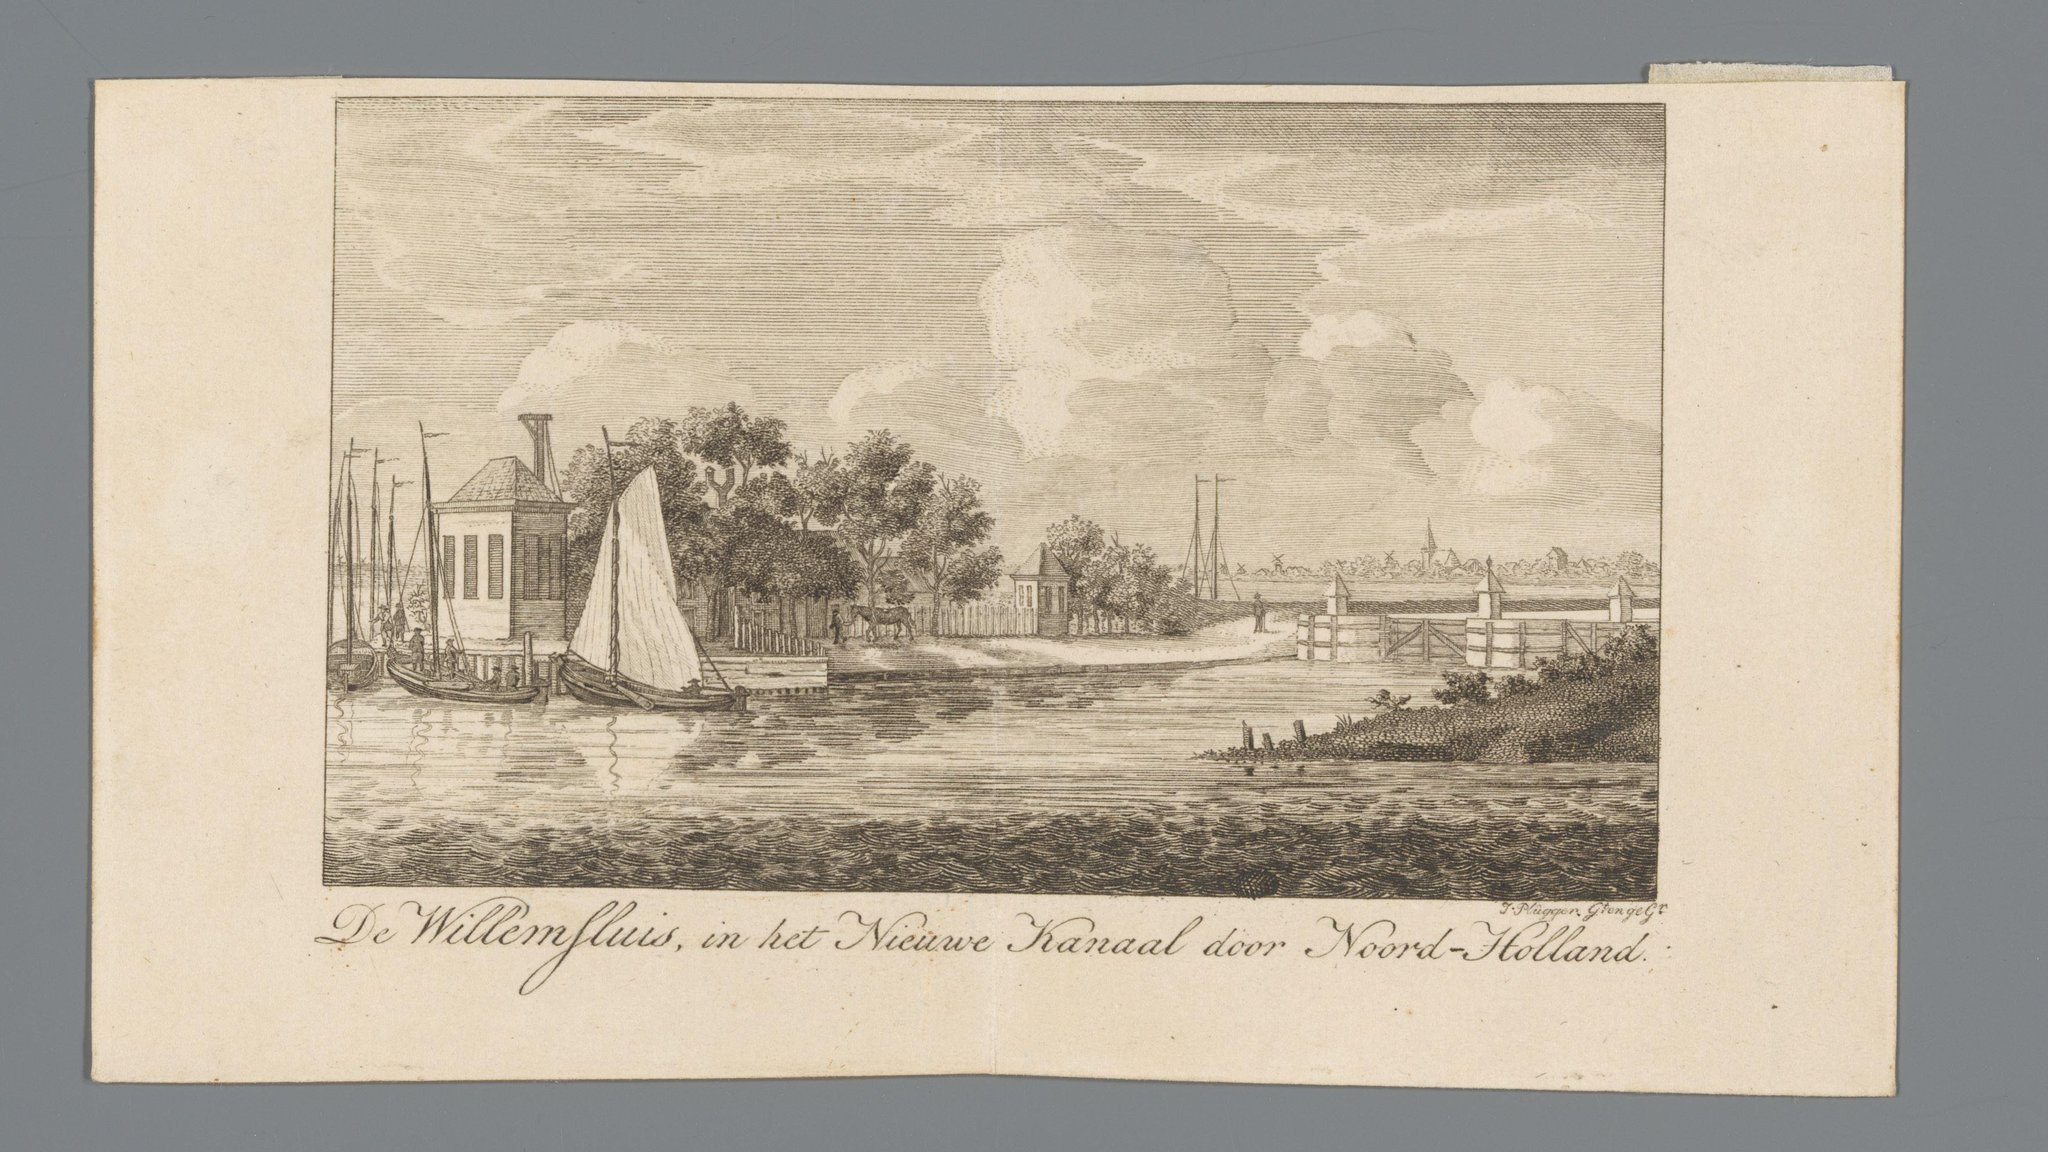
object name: print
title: De Willemsluis, in het Nieuwe Kanaal door Noord-Holland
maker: jacob plügger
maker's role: print maker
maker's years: 1795-1871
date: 1823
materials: paper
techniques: etching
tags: sluice, weir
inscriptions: collector's mark: Lugt 2233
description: De voorhaven van het Noordhollandsch Kanaal met de Willemsluis (Schutsluis Willem I) en links het Tolhuis, gezien vanaf het IJ met op de achtergrond Buiksloot.